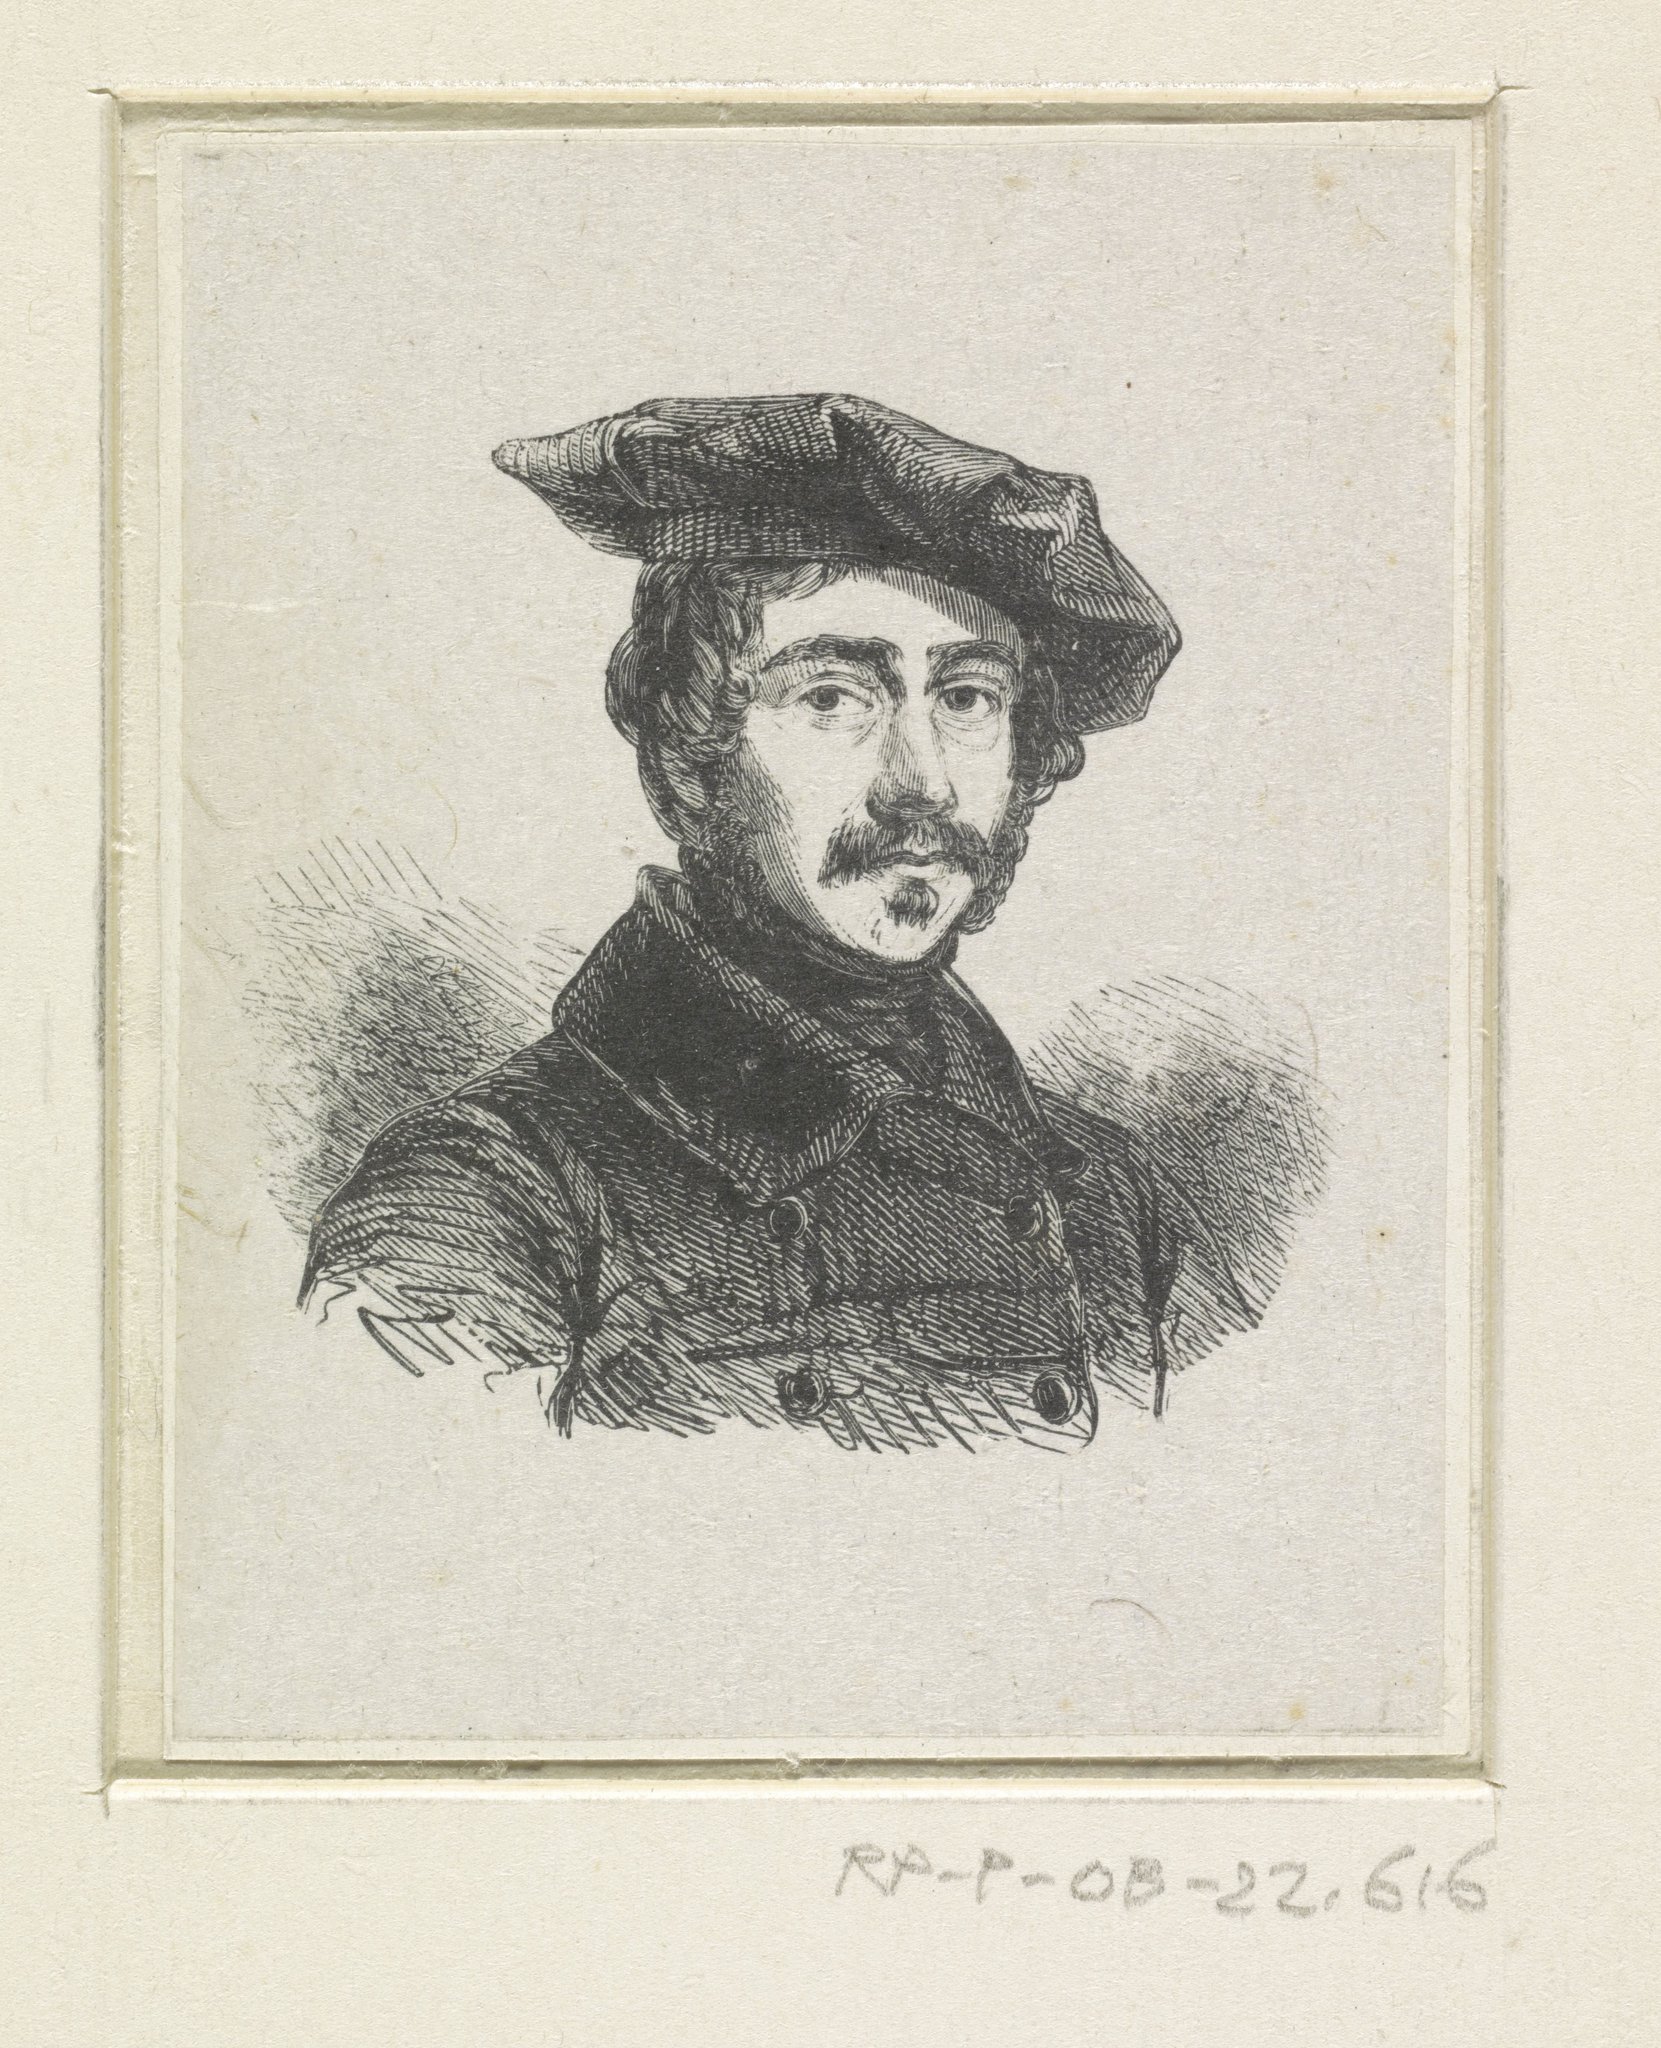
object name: print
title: Portret van Marinus Adrianus Koekkoek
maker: Anonymous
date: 1817-1918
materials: paper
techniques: engraving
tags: middelburg, amsterdam, draughtsman, marinus adrianus koekkoek (i), historical persons, portrait, self-portrait of painter, portrait, self-portrait of artist